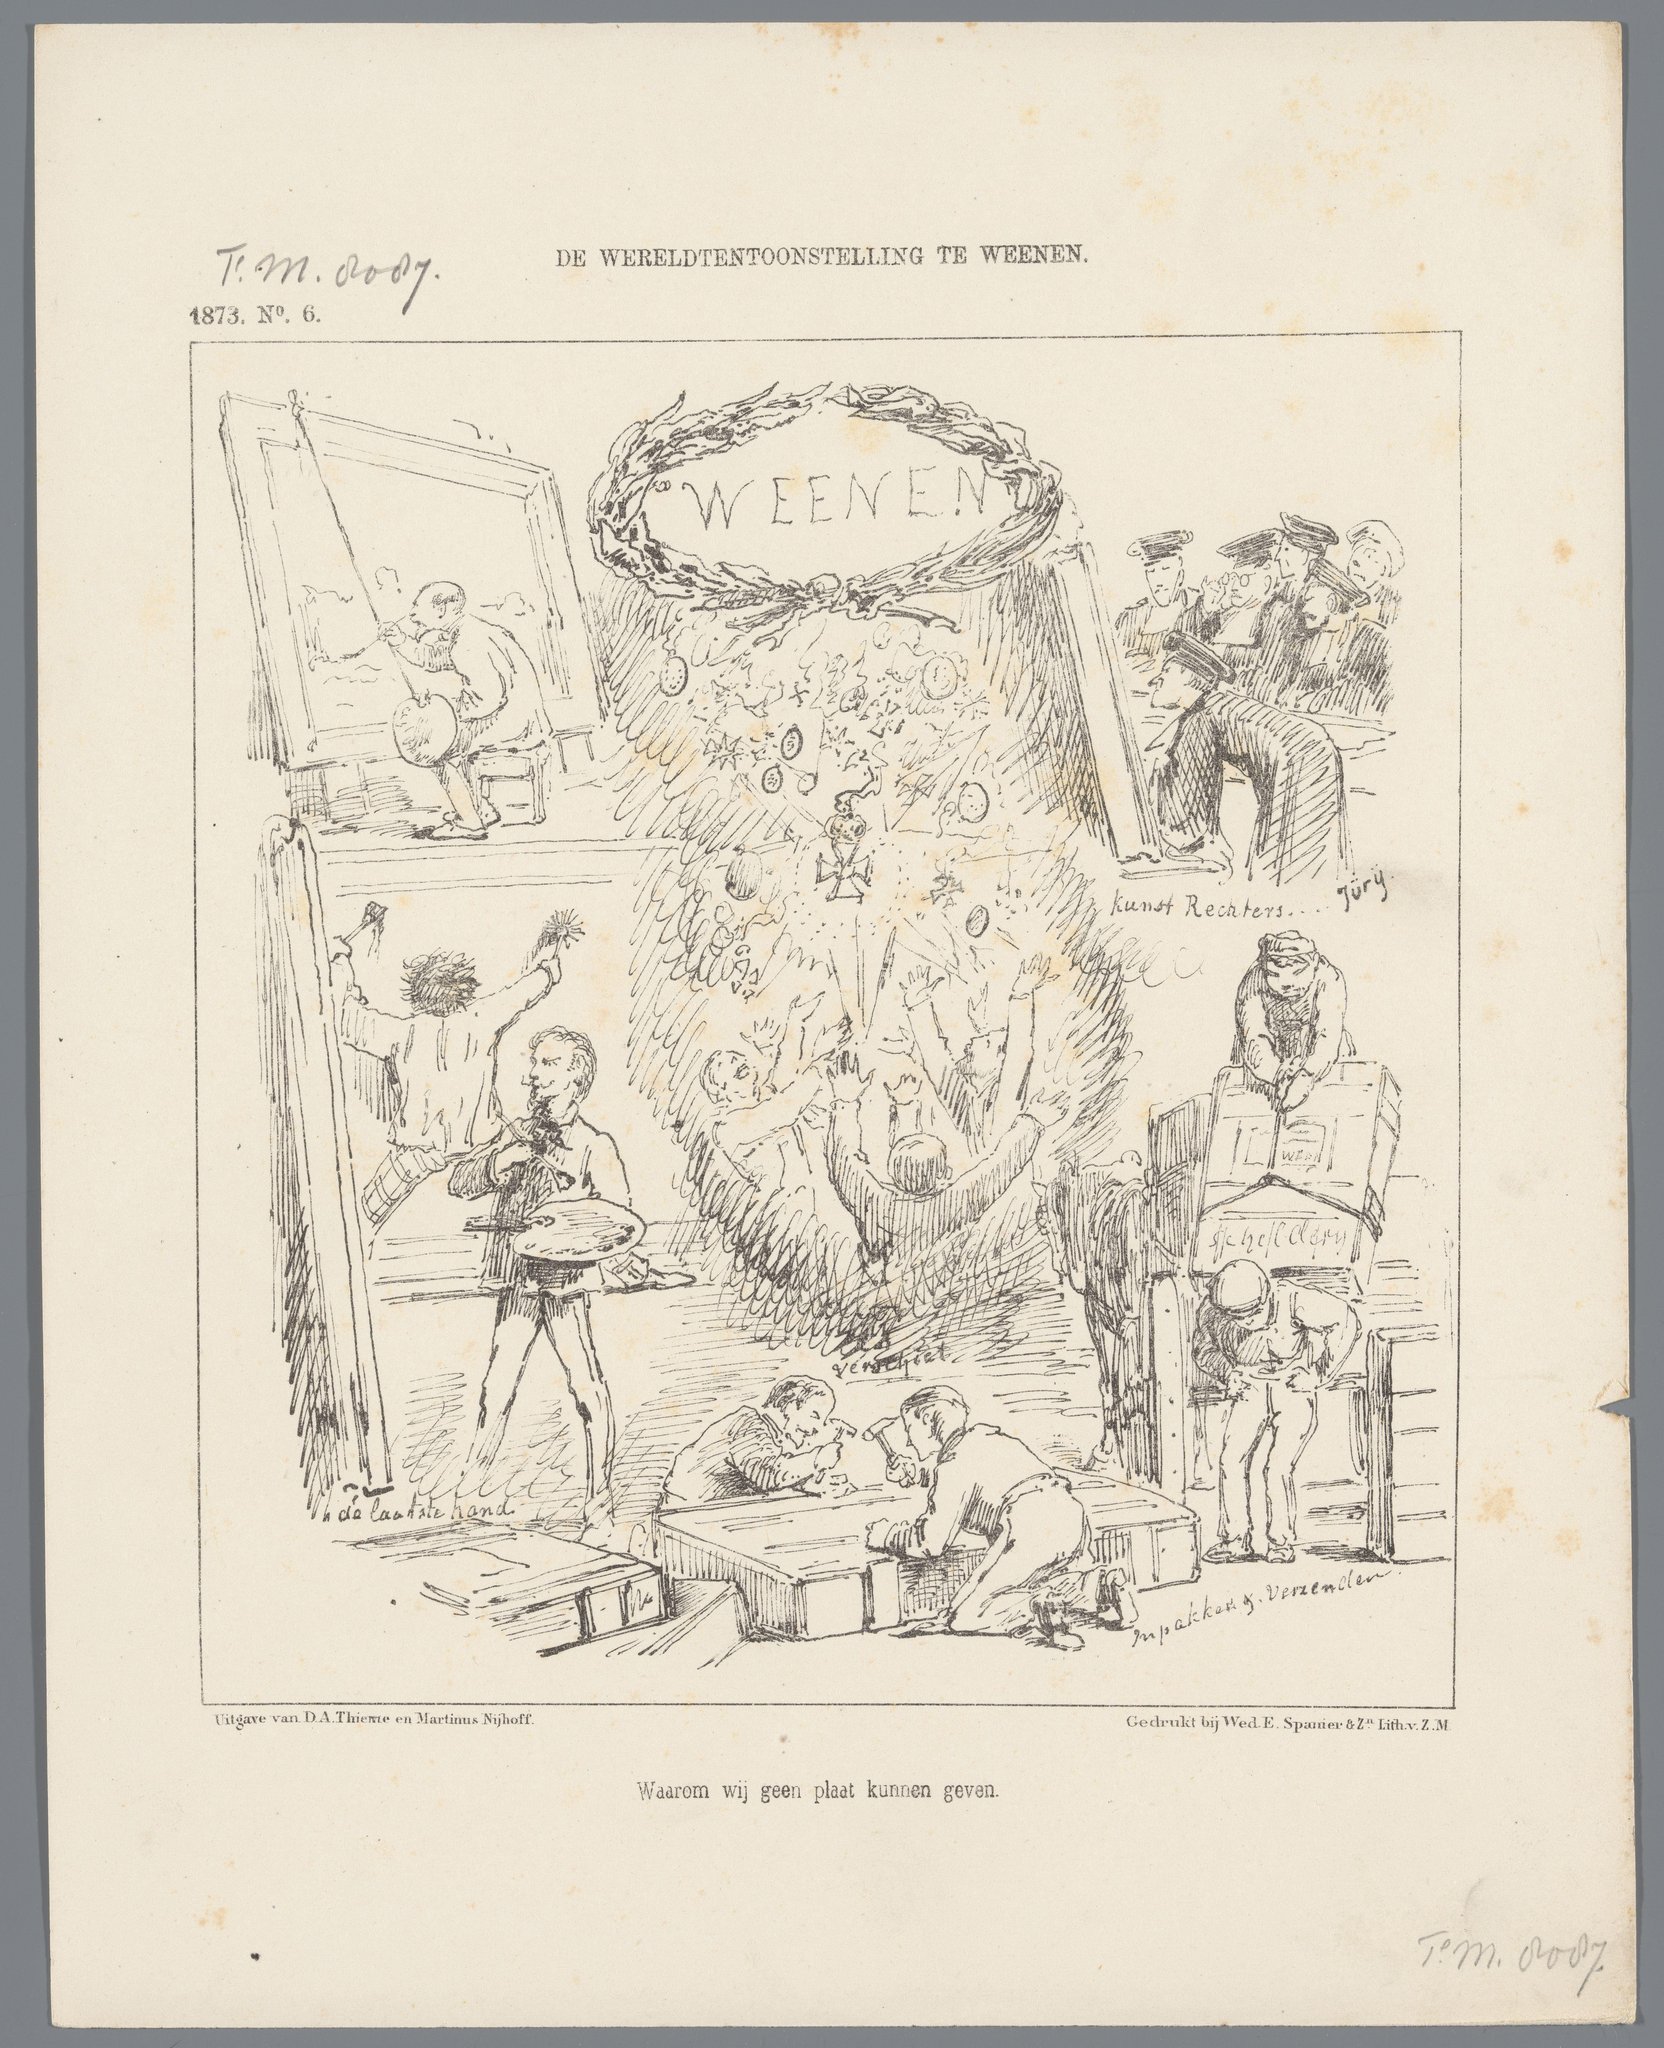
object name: print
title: De wereldtentoonstelling te Weenen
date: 1873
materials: paper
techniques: lithograph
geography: netherlands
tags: world fair, world exhibition, vienna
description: Spotprent over de wereldtentoonstelling te Wenen. Plaat verschenen bij het weekblad De Nederlandsche Spectator, nr. 6, 1873.